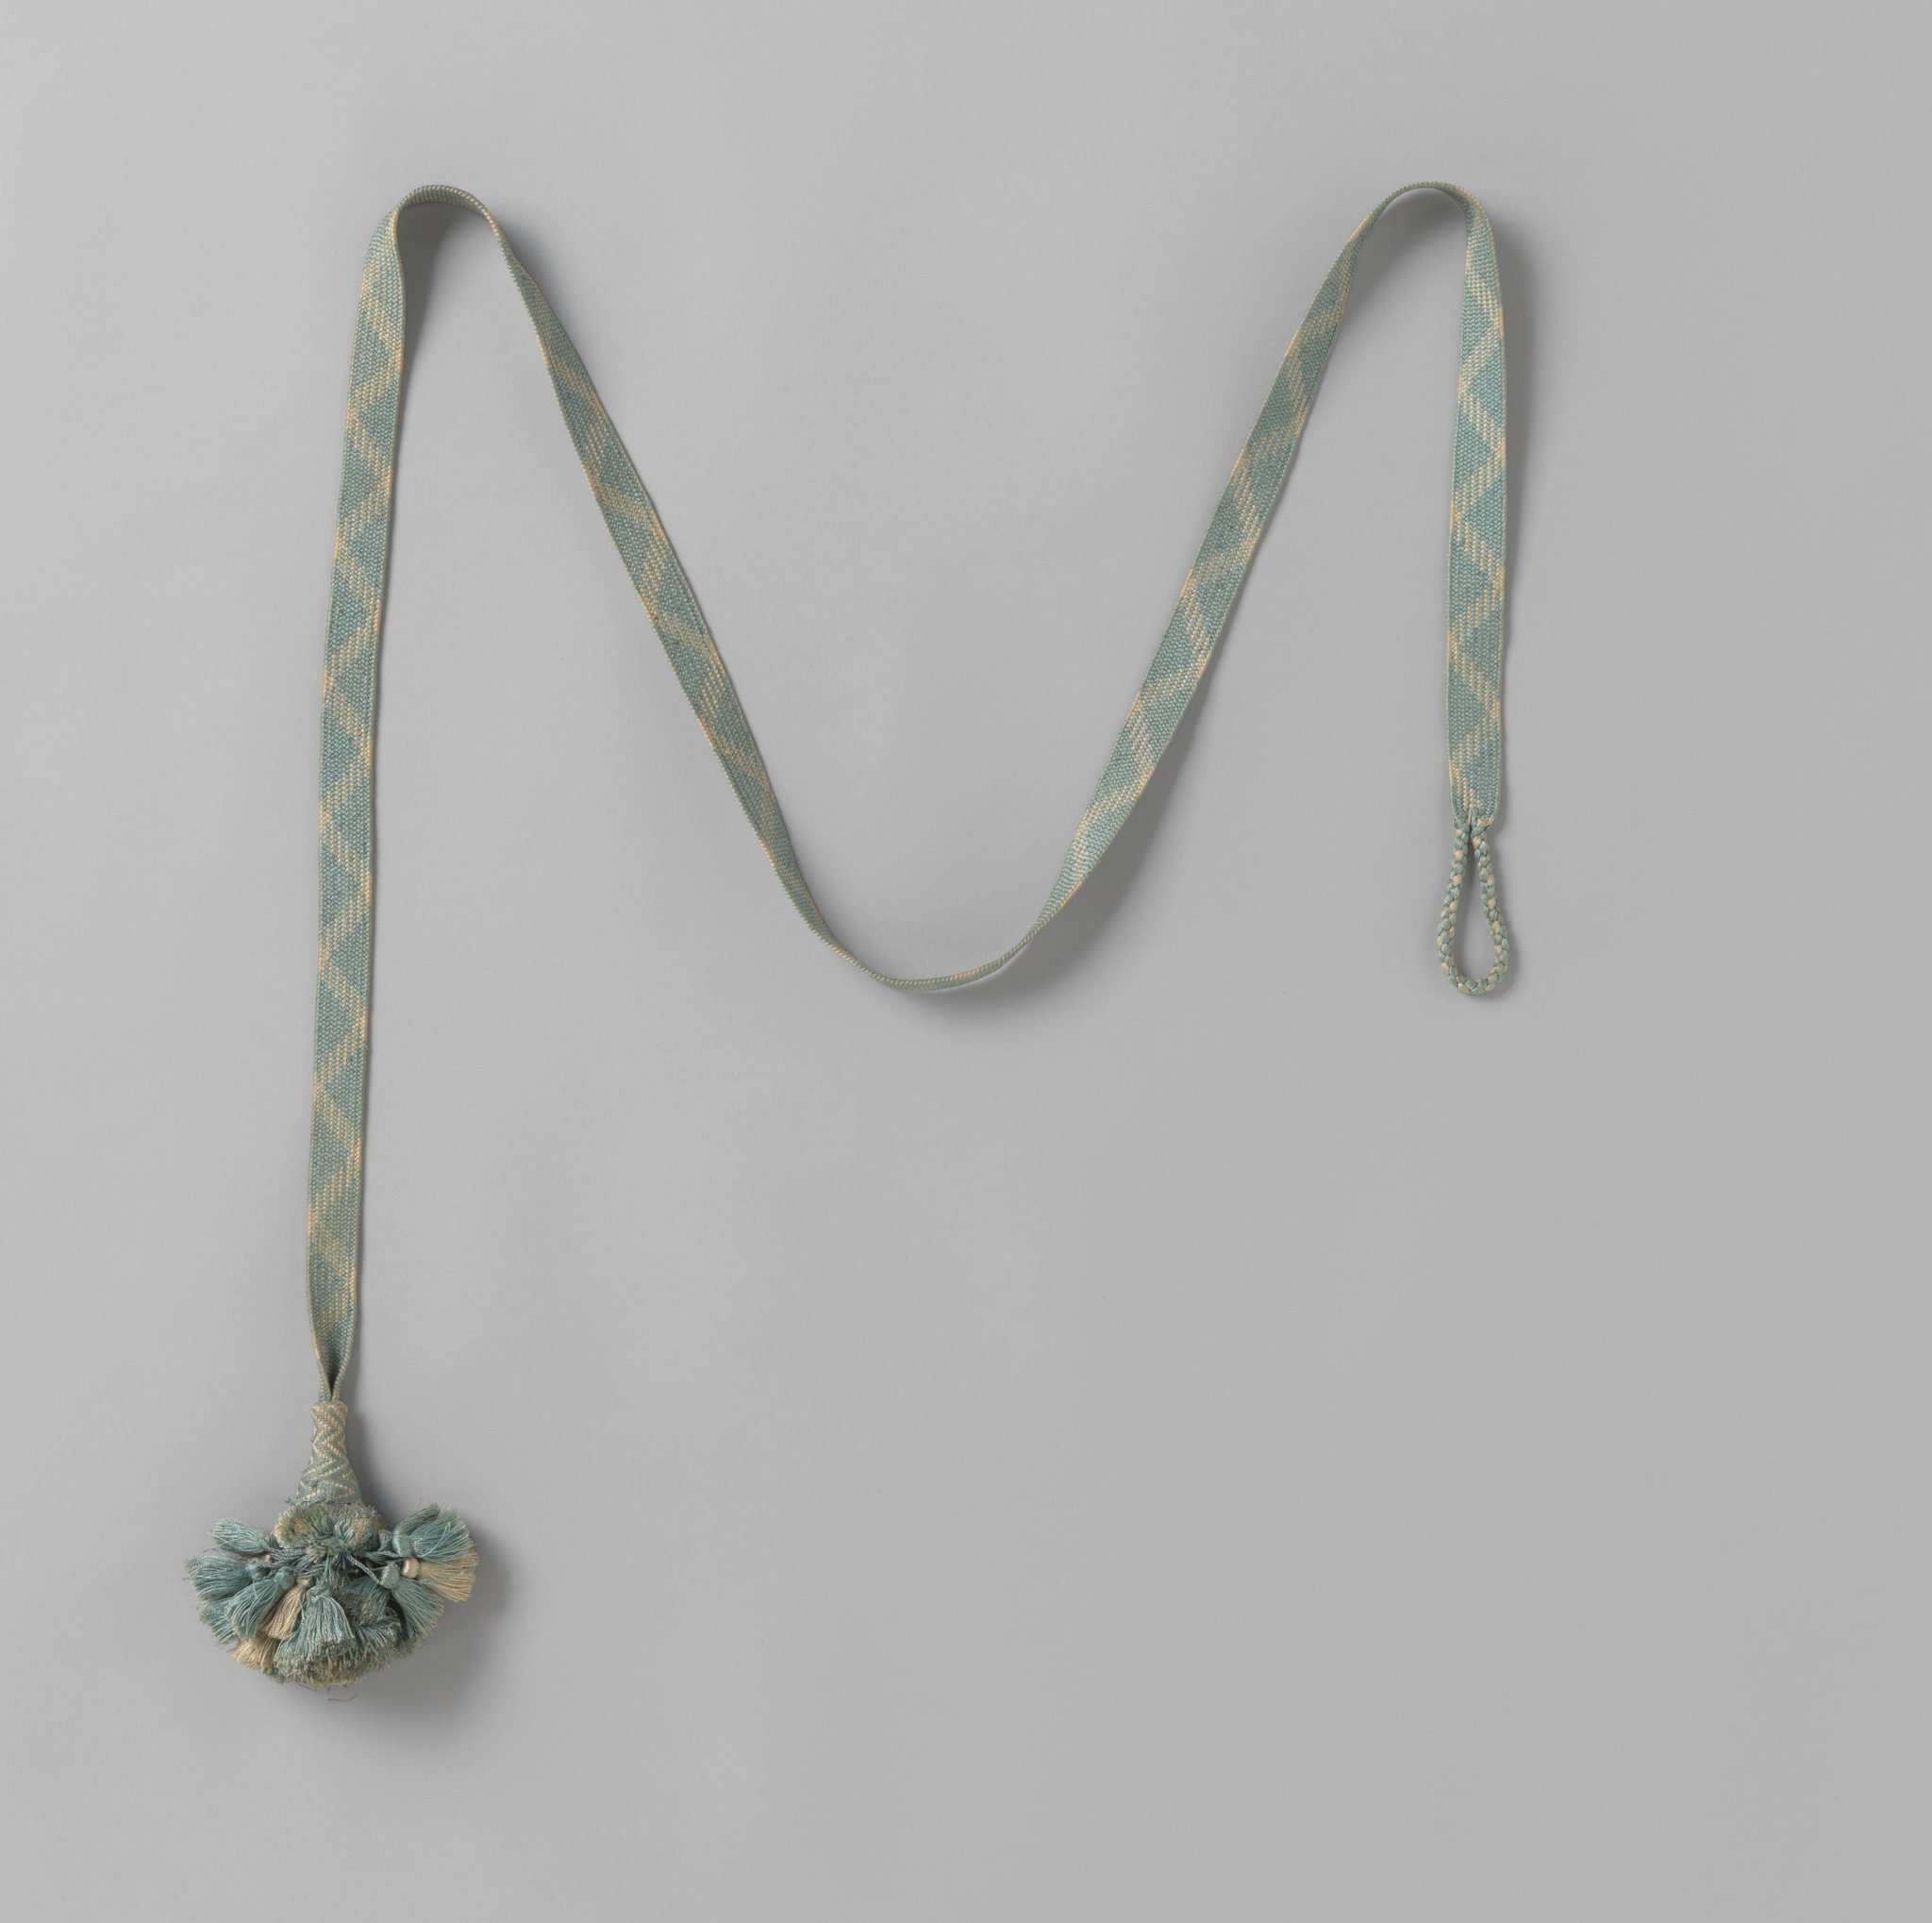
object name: band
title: Band van blauwgrijze zijde, met kwast, Louis XIV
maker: Anonymous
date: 1889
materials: silk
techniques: weave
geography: western europe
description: Band van blauwgrijze zijde, met kwast, Louis XIV.